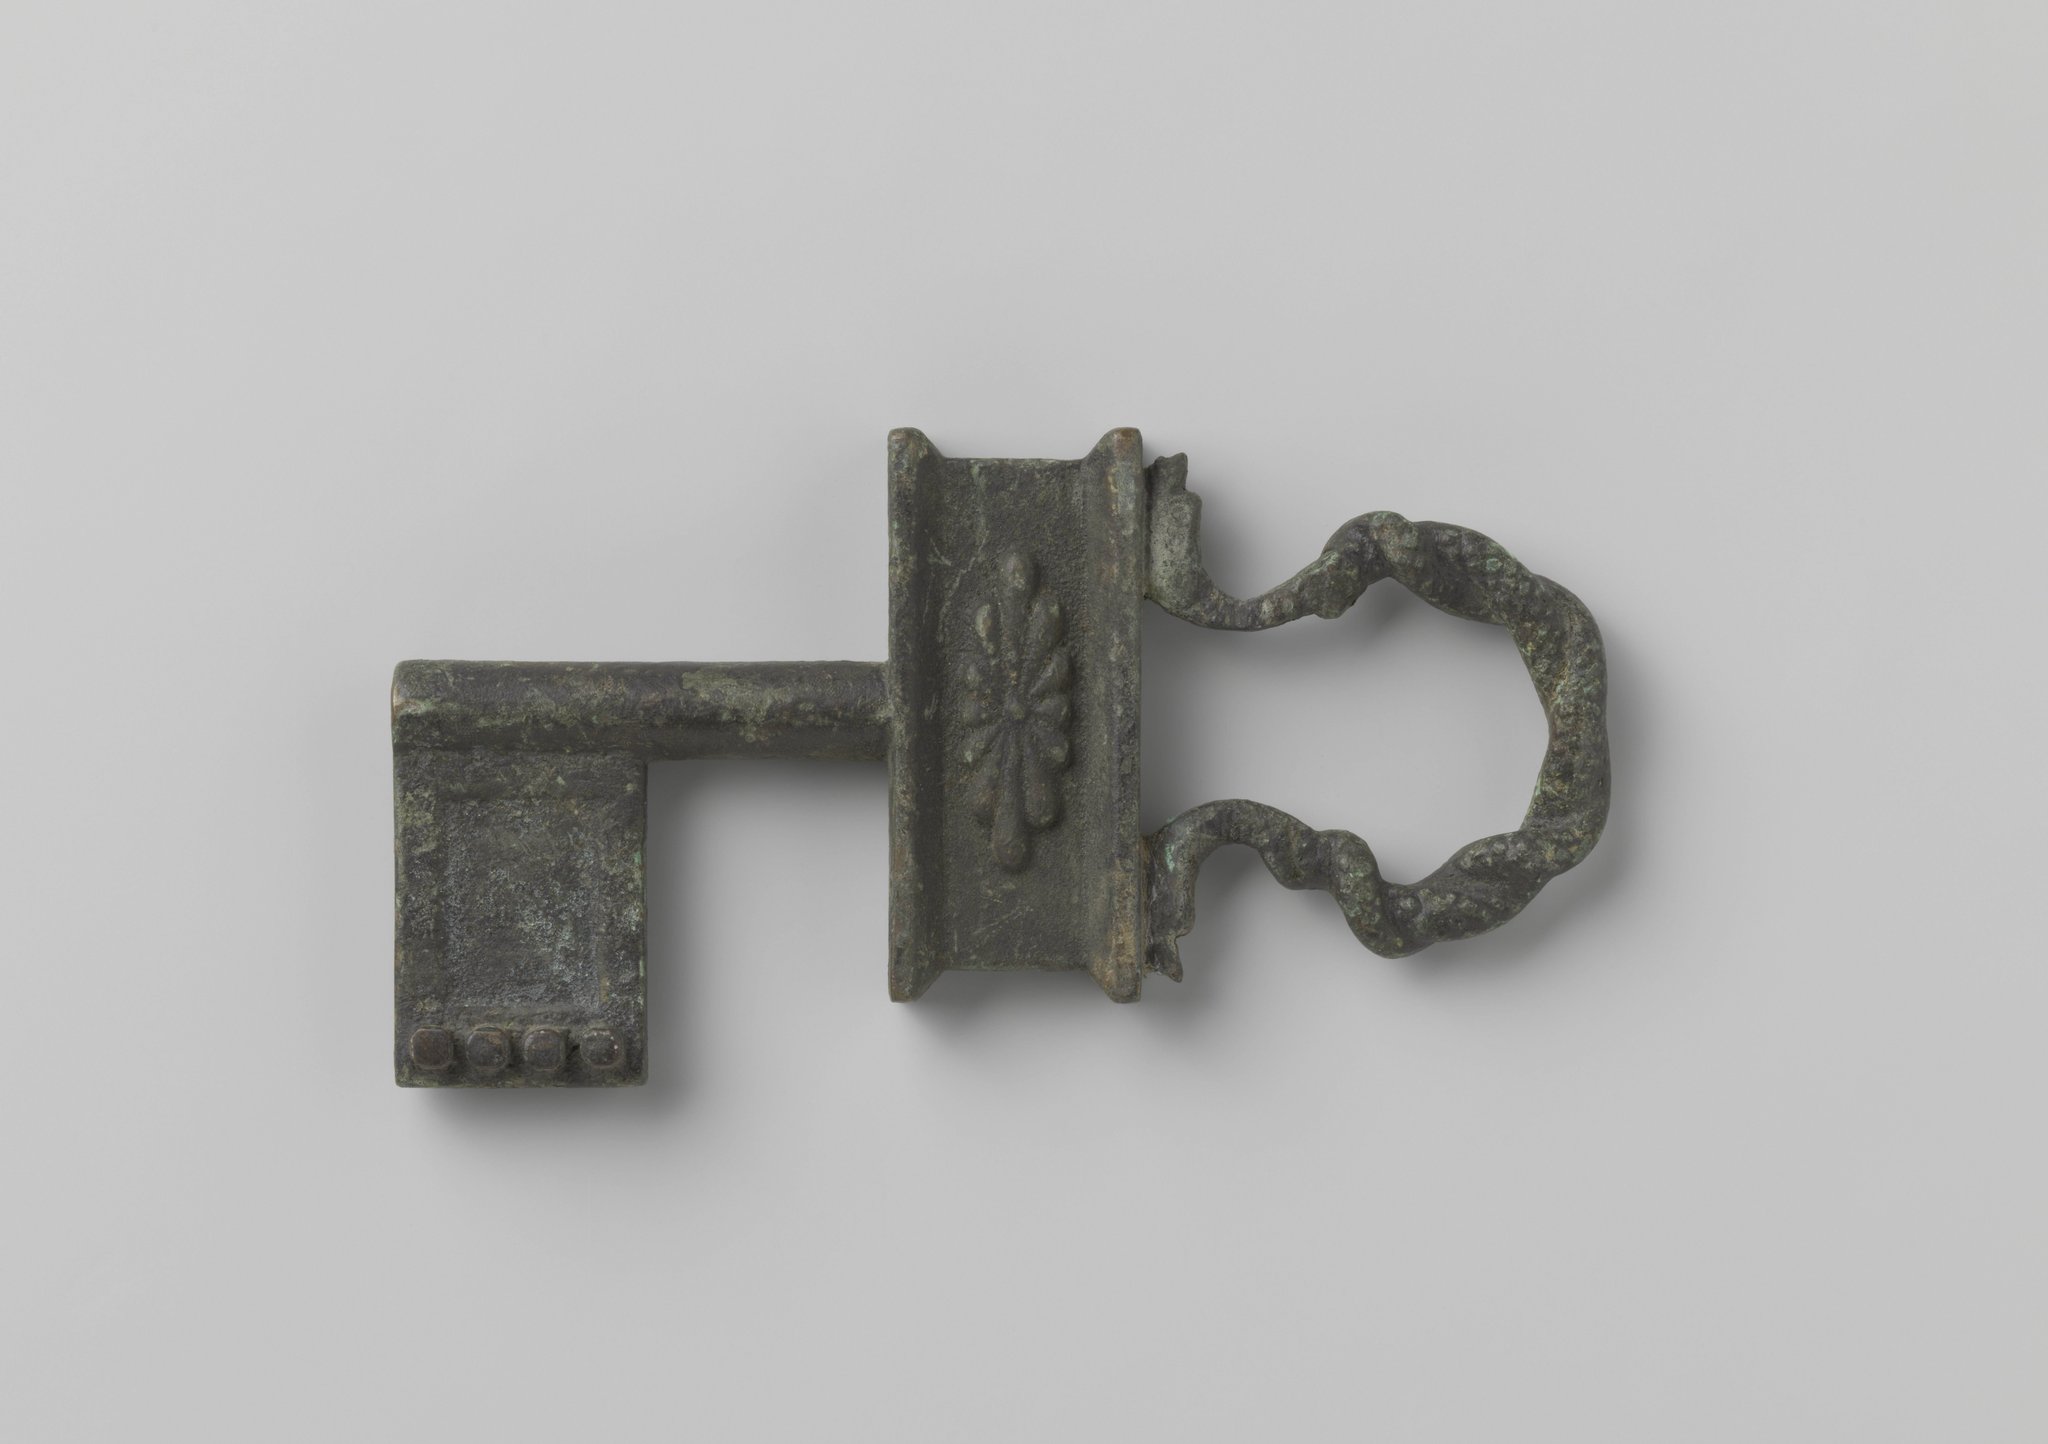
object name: key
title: Ceremoniesleutel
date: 1400-1950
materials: bronze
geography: rome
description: Ceremoniesleutel waarvan het oog gevormd wordt door ineen gekronkelde slangen steunend op een breed vierhoekig vlak met roset onder en boven afgesloten door een geprofileerde rand. Massieve, vierhoekige baard met vier rechthoekig daarop geplaatste korte tanden.